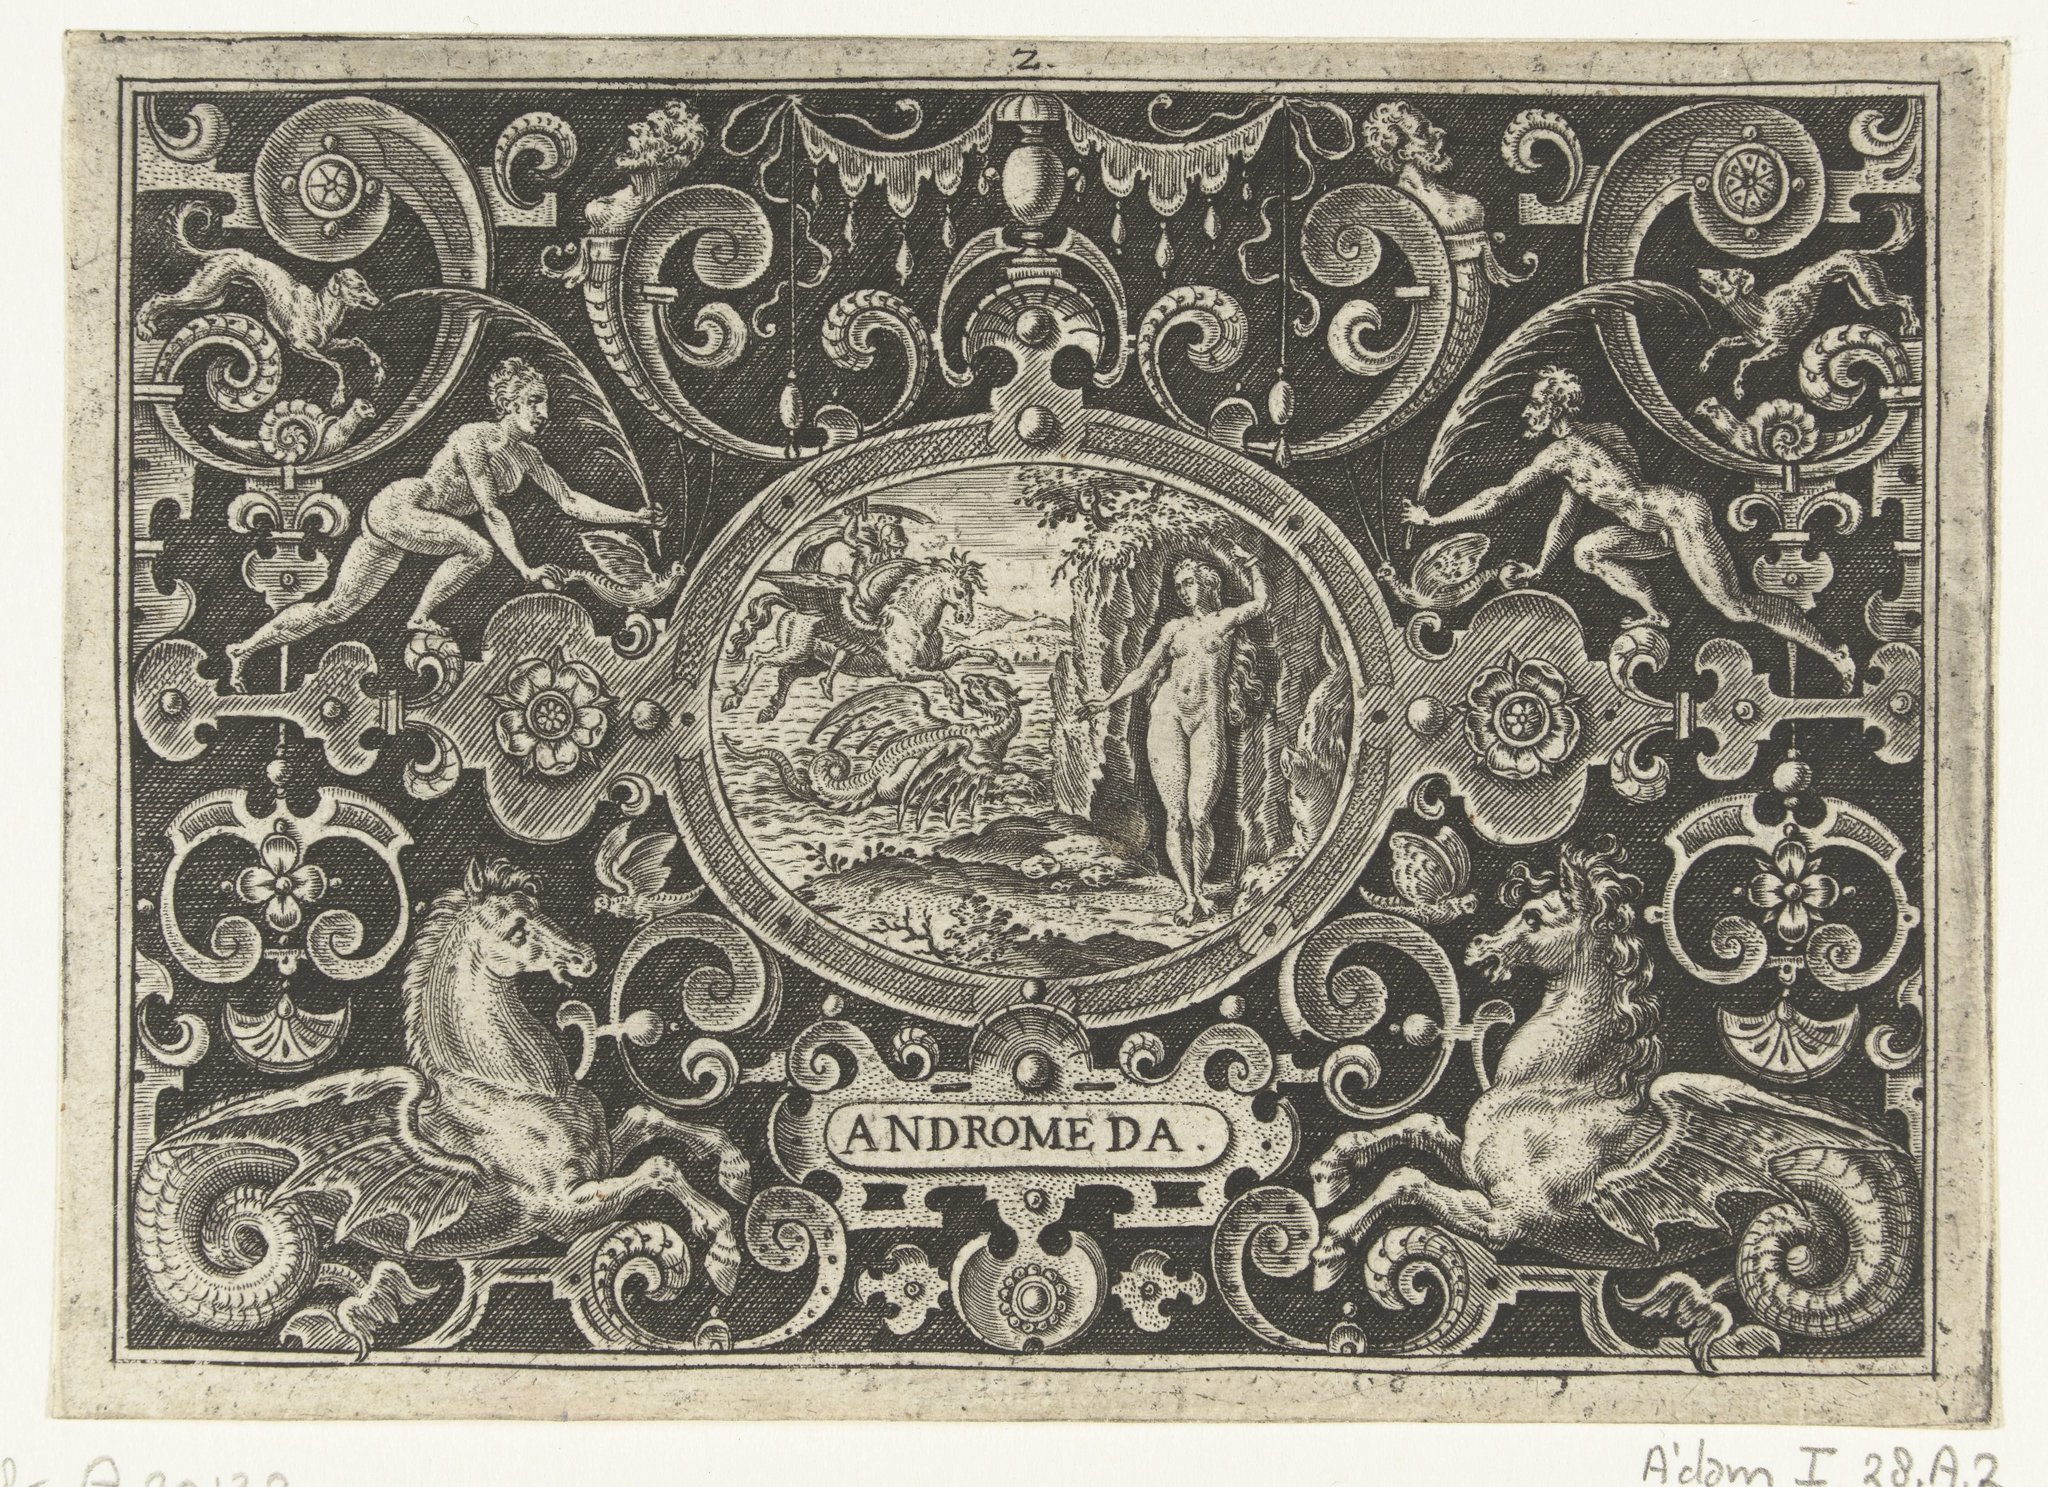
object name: print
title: ANDROMEDA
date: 1584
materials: paper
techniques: engraving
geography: netherlands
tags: perseus kills the sea monster (or turns it into stone by showing it the gorgon's head) to release andromeda; sometimes her parents cepheus and cassiopea watch the scene, sea-horse, hippocamp, 'hippocampus', (horse/fish) (mythological hybrid monster), ornament ~ cartouche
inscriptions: number: ‘2’, title: ‘ANDROMEDA’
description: Cartouche met Perseus die, gezeten op het paard Pegasus, het zeemonster bestrijdt. Rechts Andromeda geketend aan de rots. Ovaal cartouche in omlijsting van figuren en zeemonsters tegen gearceerde achtergrond.